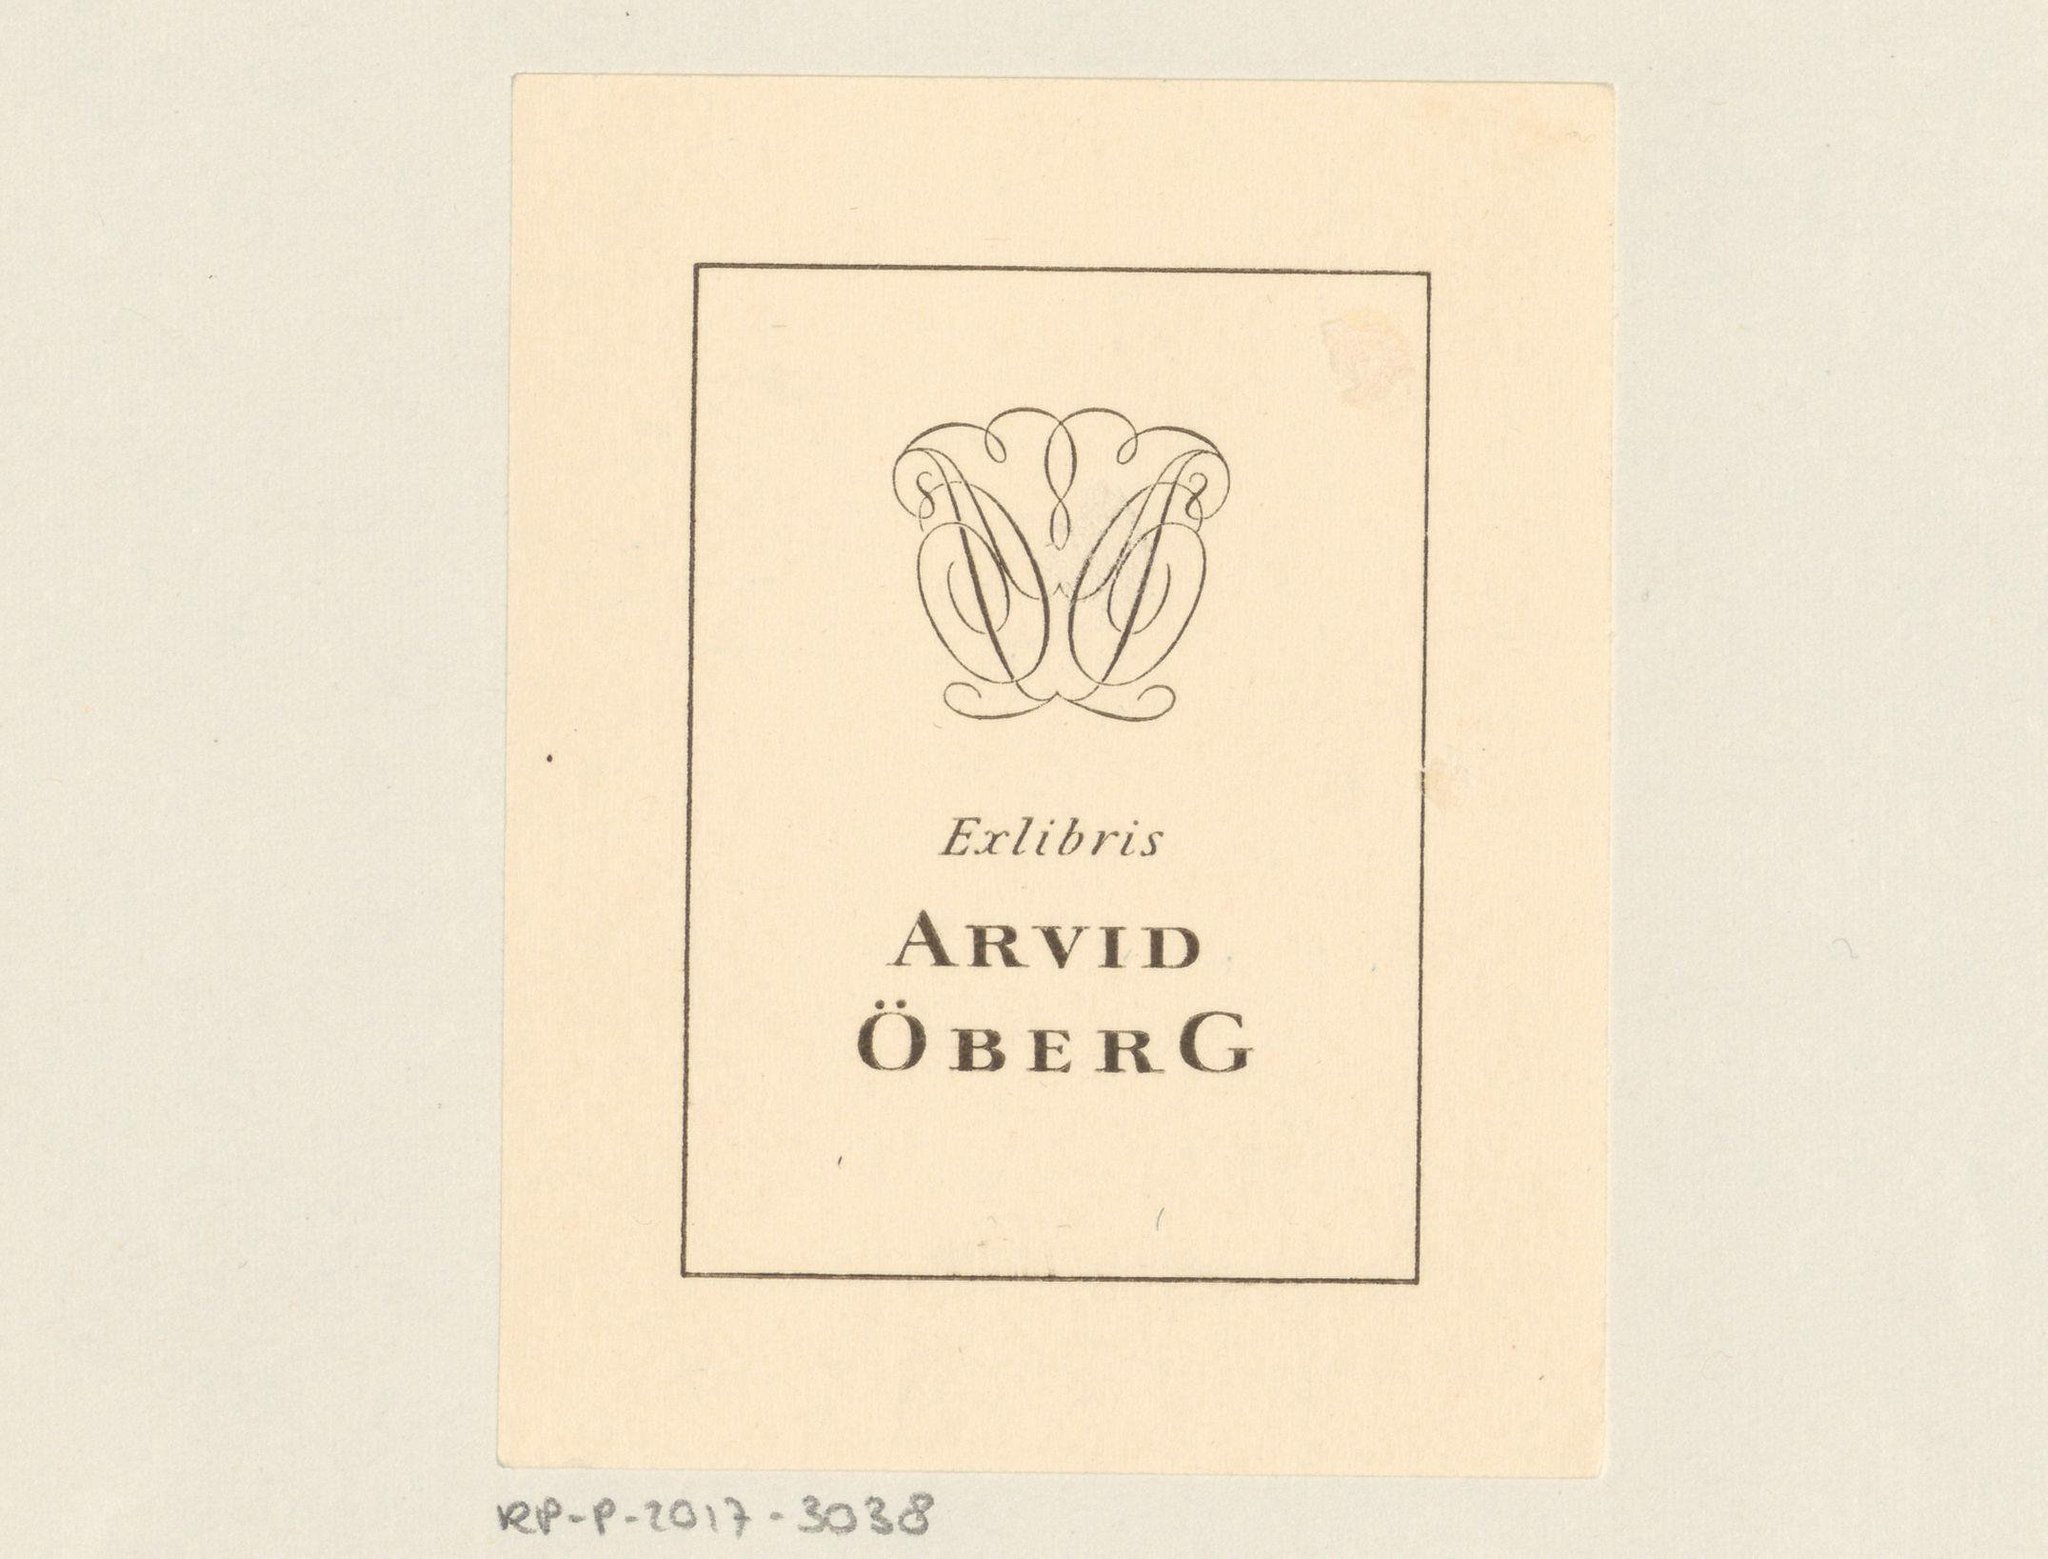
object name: bookplate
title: Ex libris van Arvid Öberg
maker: Anonymous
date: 1900-1999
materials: paper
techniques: printing block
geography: sweden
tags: arvid öberg